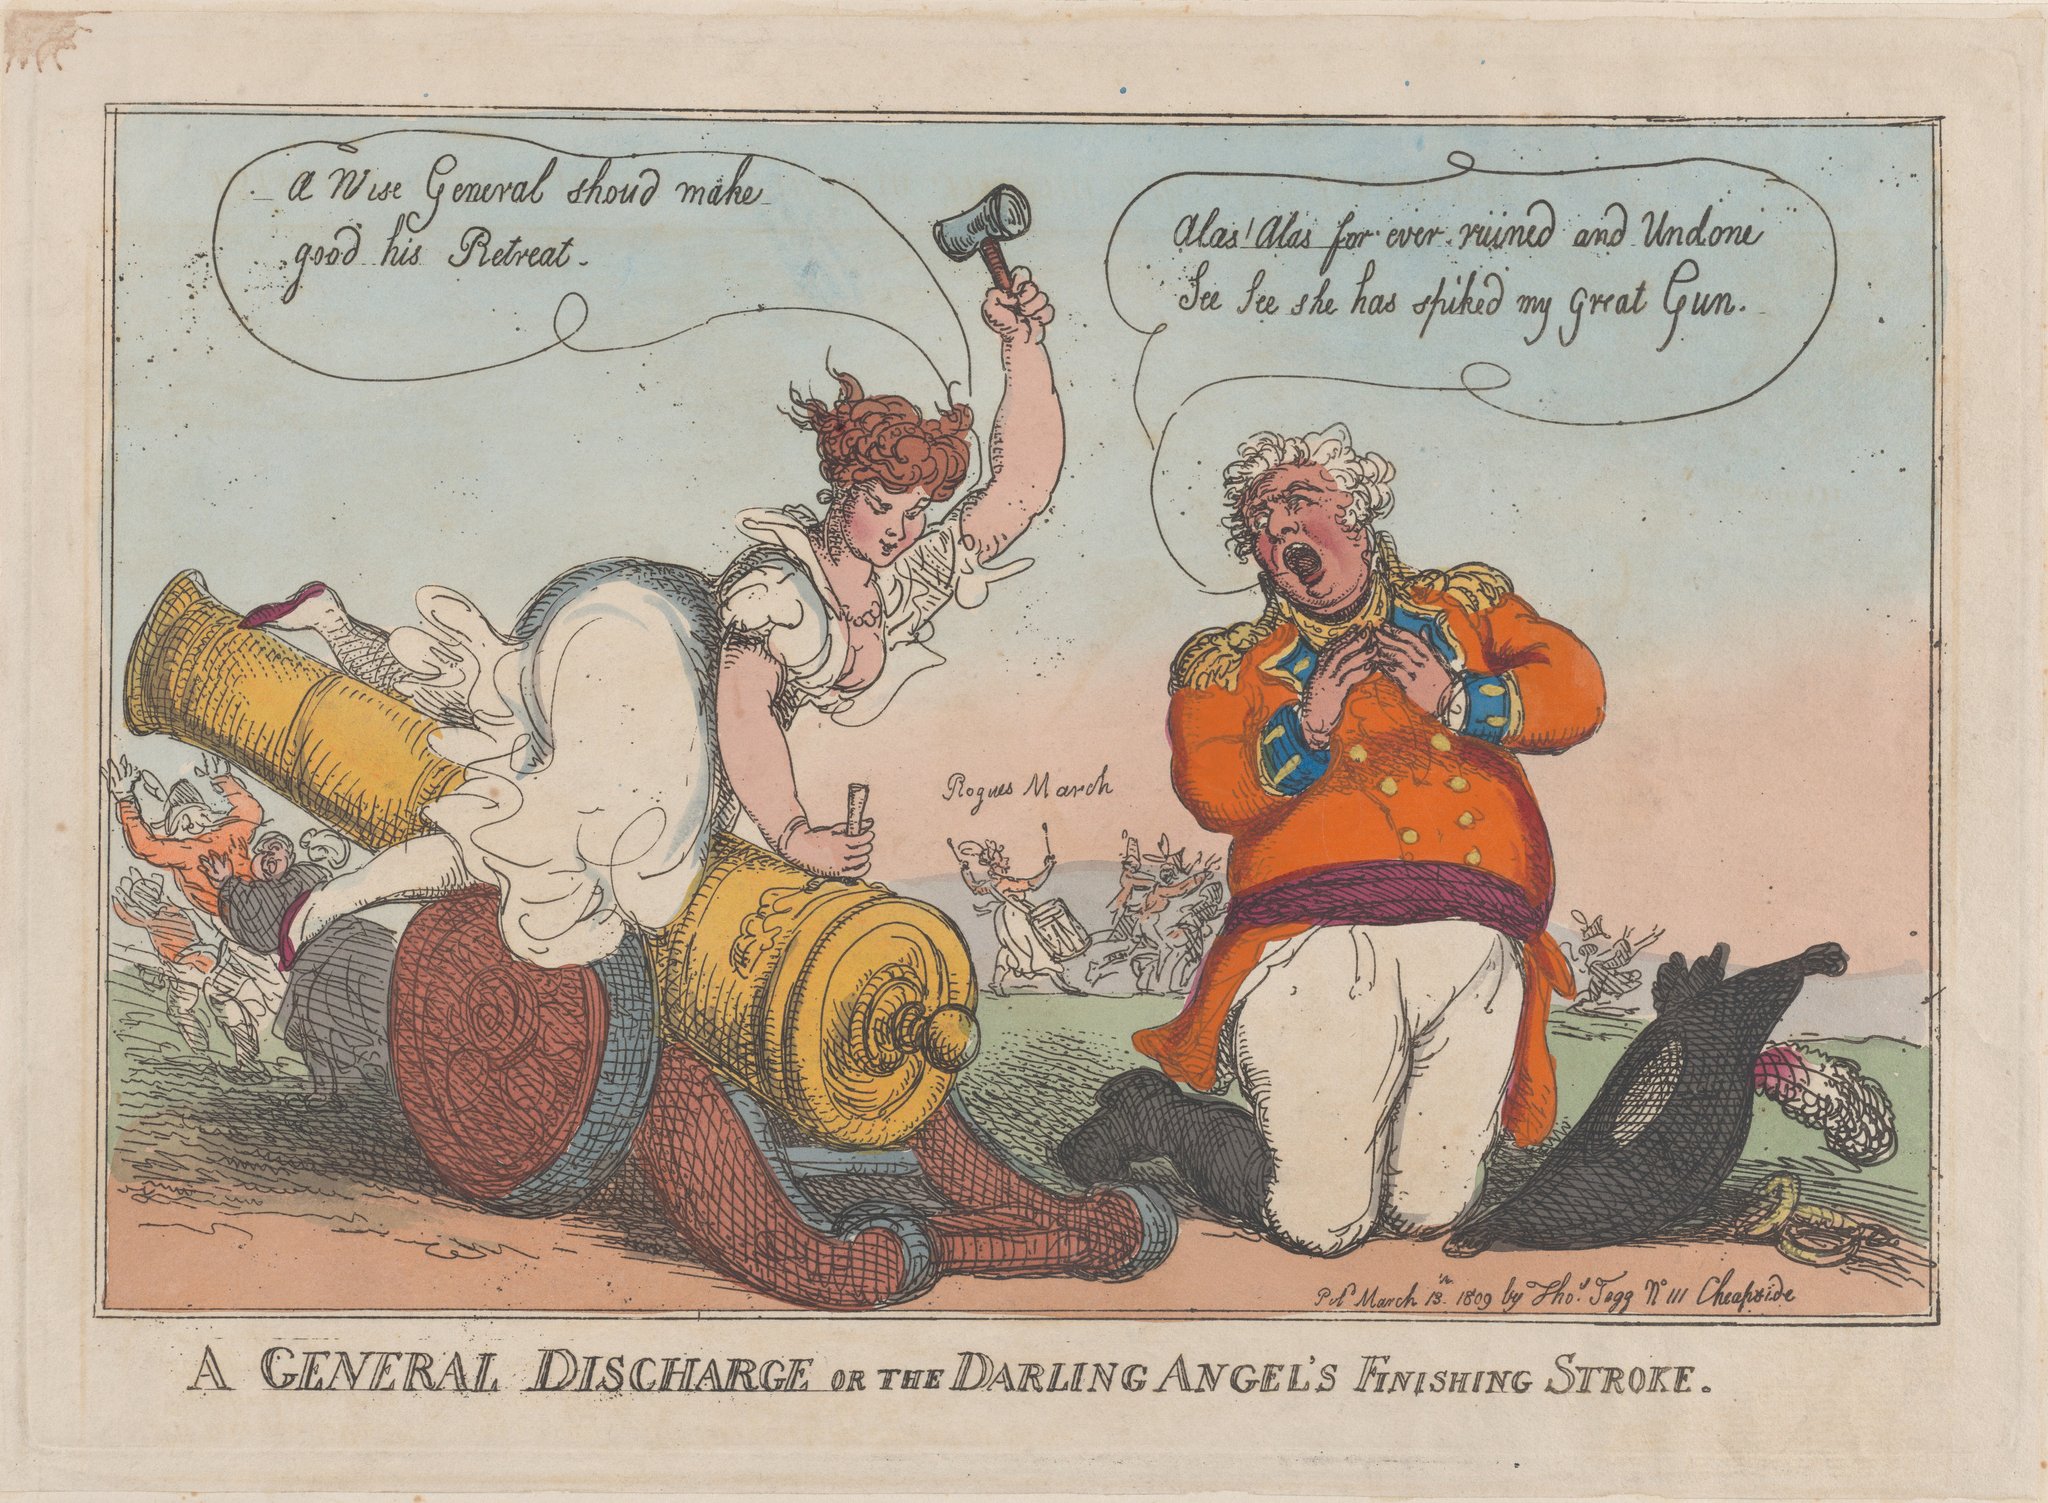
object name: print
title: A General Discharge or the Darling Angel's Finising Stroke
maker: thomas rowlandson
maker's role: artist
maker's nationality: british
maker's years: 1757-1827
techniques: etching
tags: satire,cannons,men,women,politics